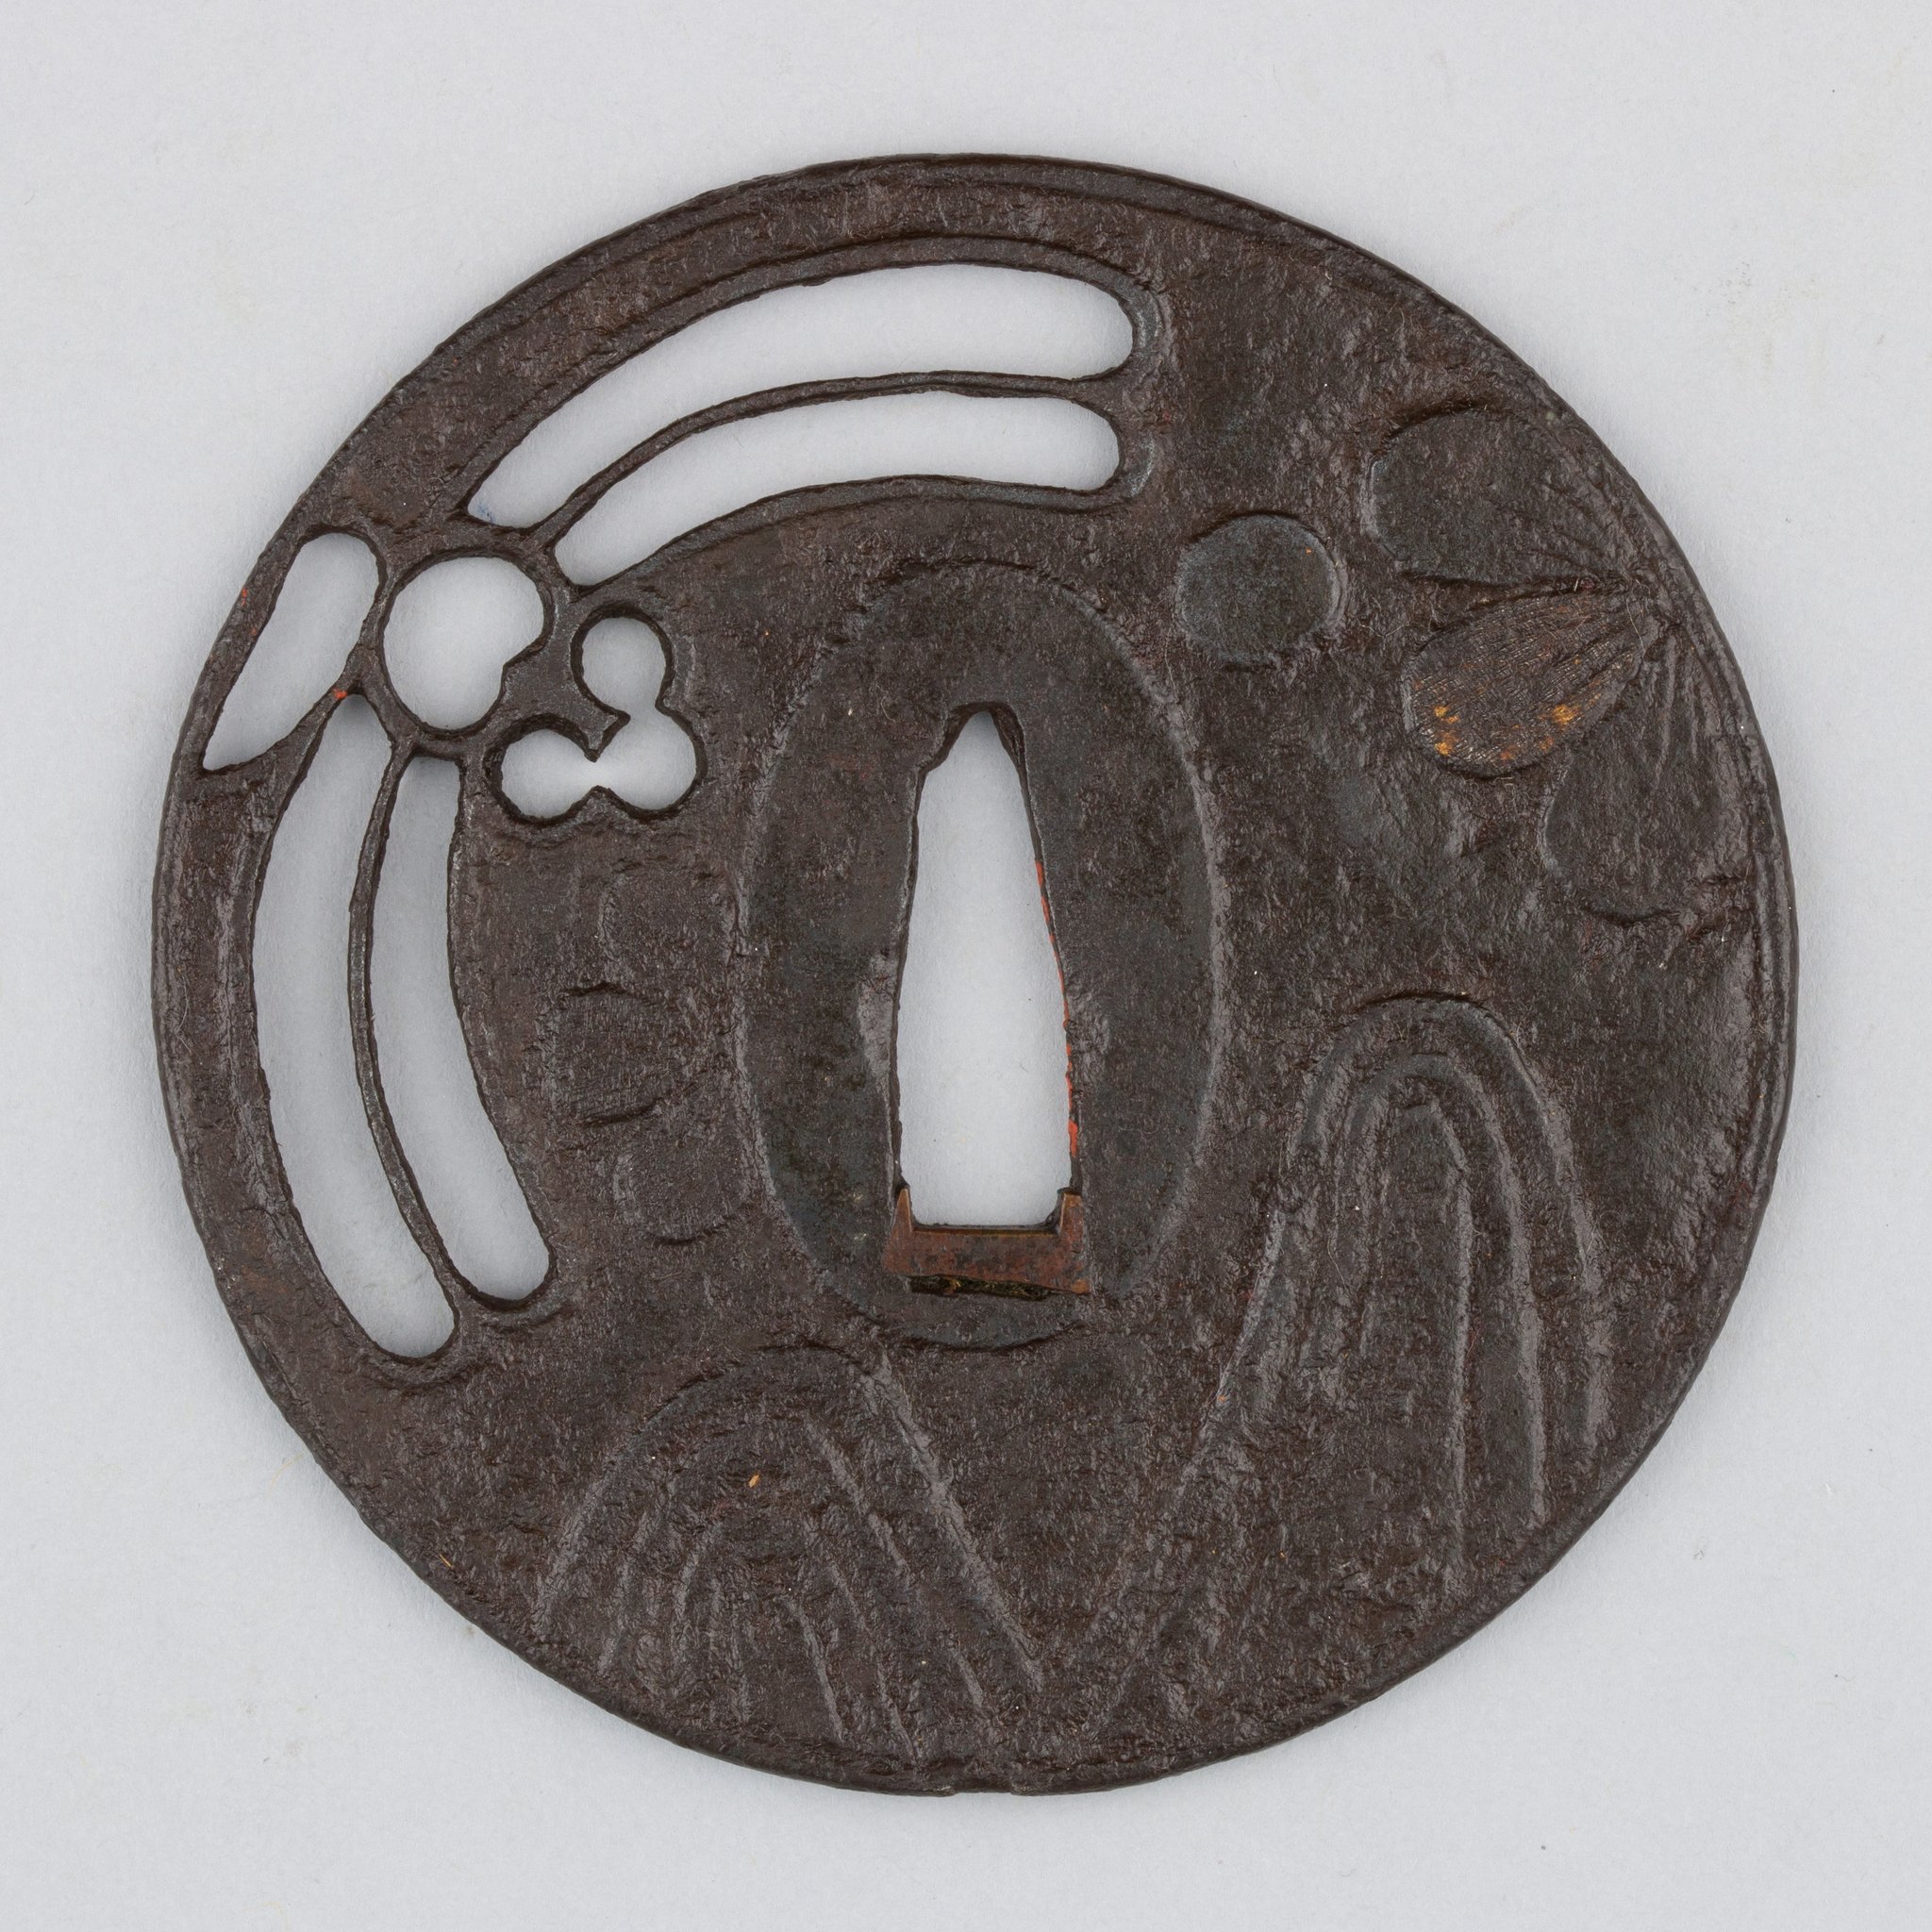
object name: sword guard tsuba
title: Sword Guard (Tsuba)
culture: japanese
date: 1401-1500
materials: copper, gold, iron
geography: japan